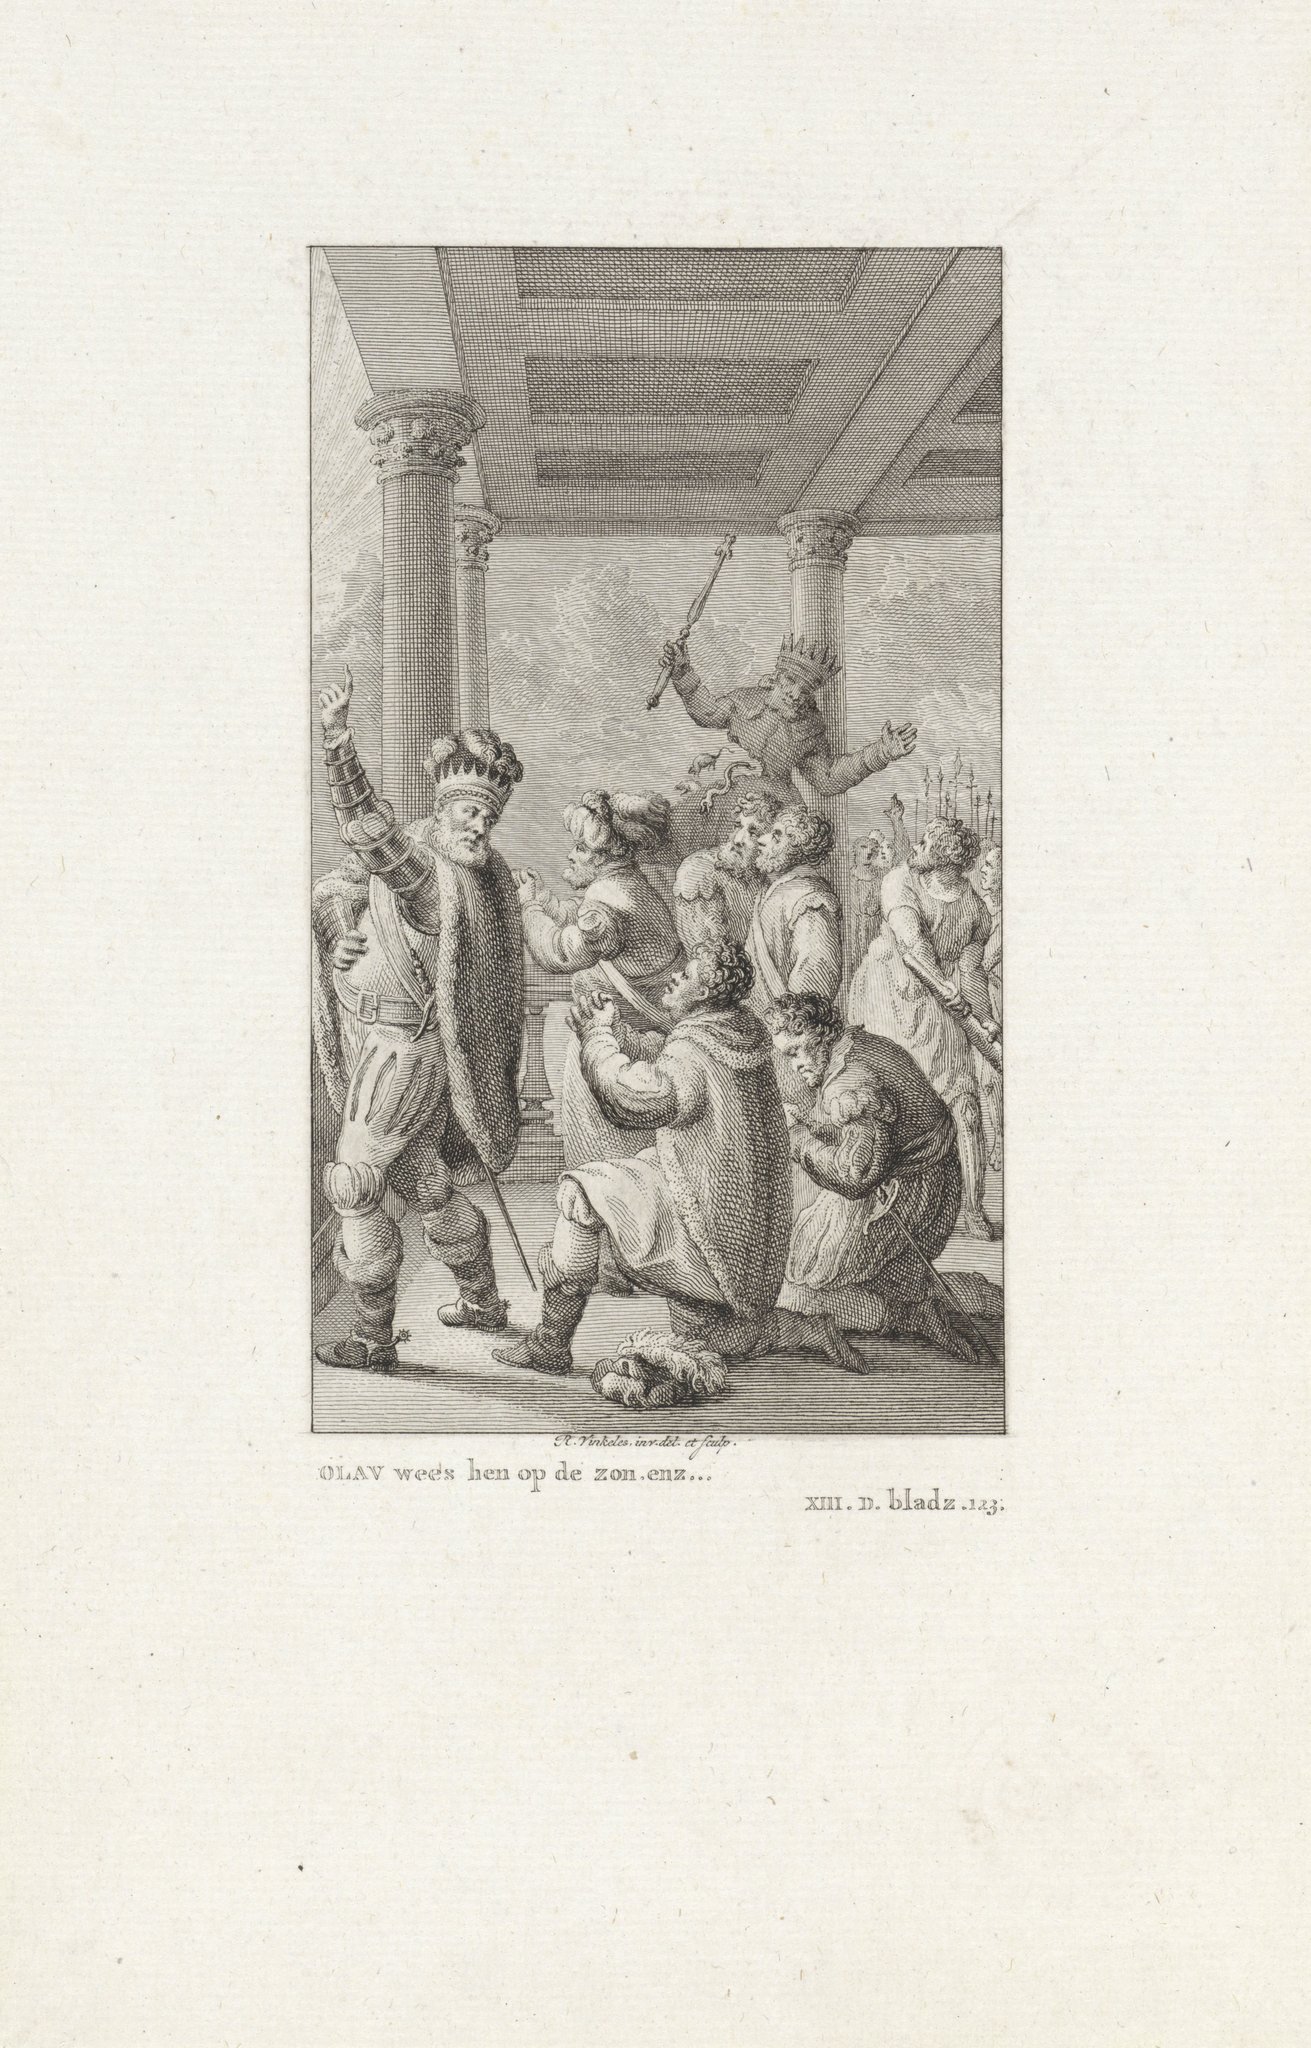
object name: book illustration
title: Olav wijst enkele biddende mannen op de zon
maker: reinier vinkeles (i)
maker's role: draughtsman, print maker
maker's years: 1741-1816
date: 1806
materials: paper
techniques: engraving, etching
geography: amsterdam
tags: spur, ruler, sovereign, kneeling figure, index finger forwards, pointing, indicating, insignia and symbols of sovereignty (crown, diadem, sceptre, orb, seal, standard, cloak, pectoral)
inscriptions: collector's mark: Lugt 240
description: Olav wijst enkele Noren op de zon als bewijs van de macht van God. Op de achtergrond vernietigt een man met zijn knuppel het beeld van Thor, waardoor de machteloosheid van deze god wordt bewezen.